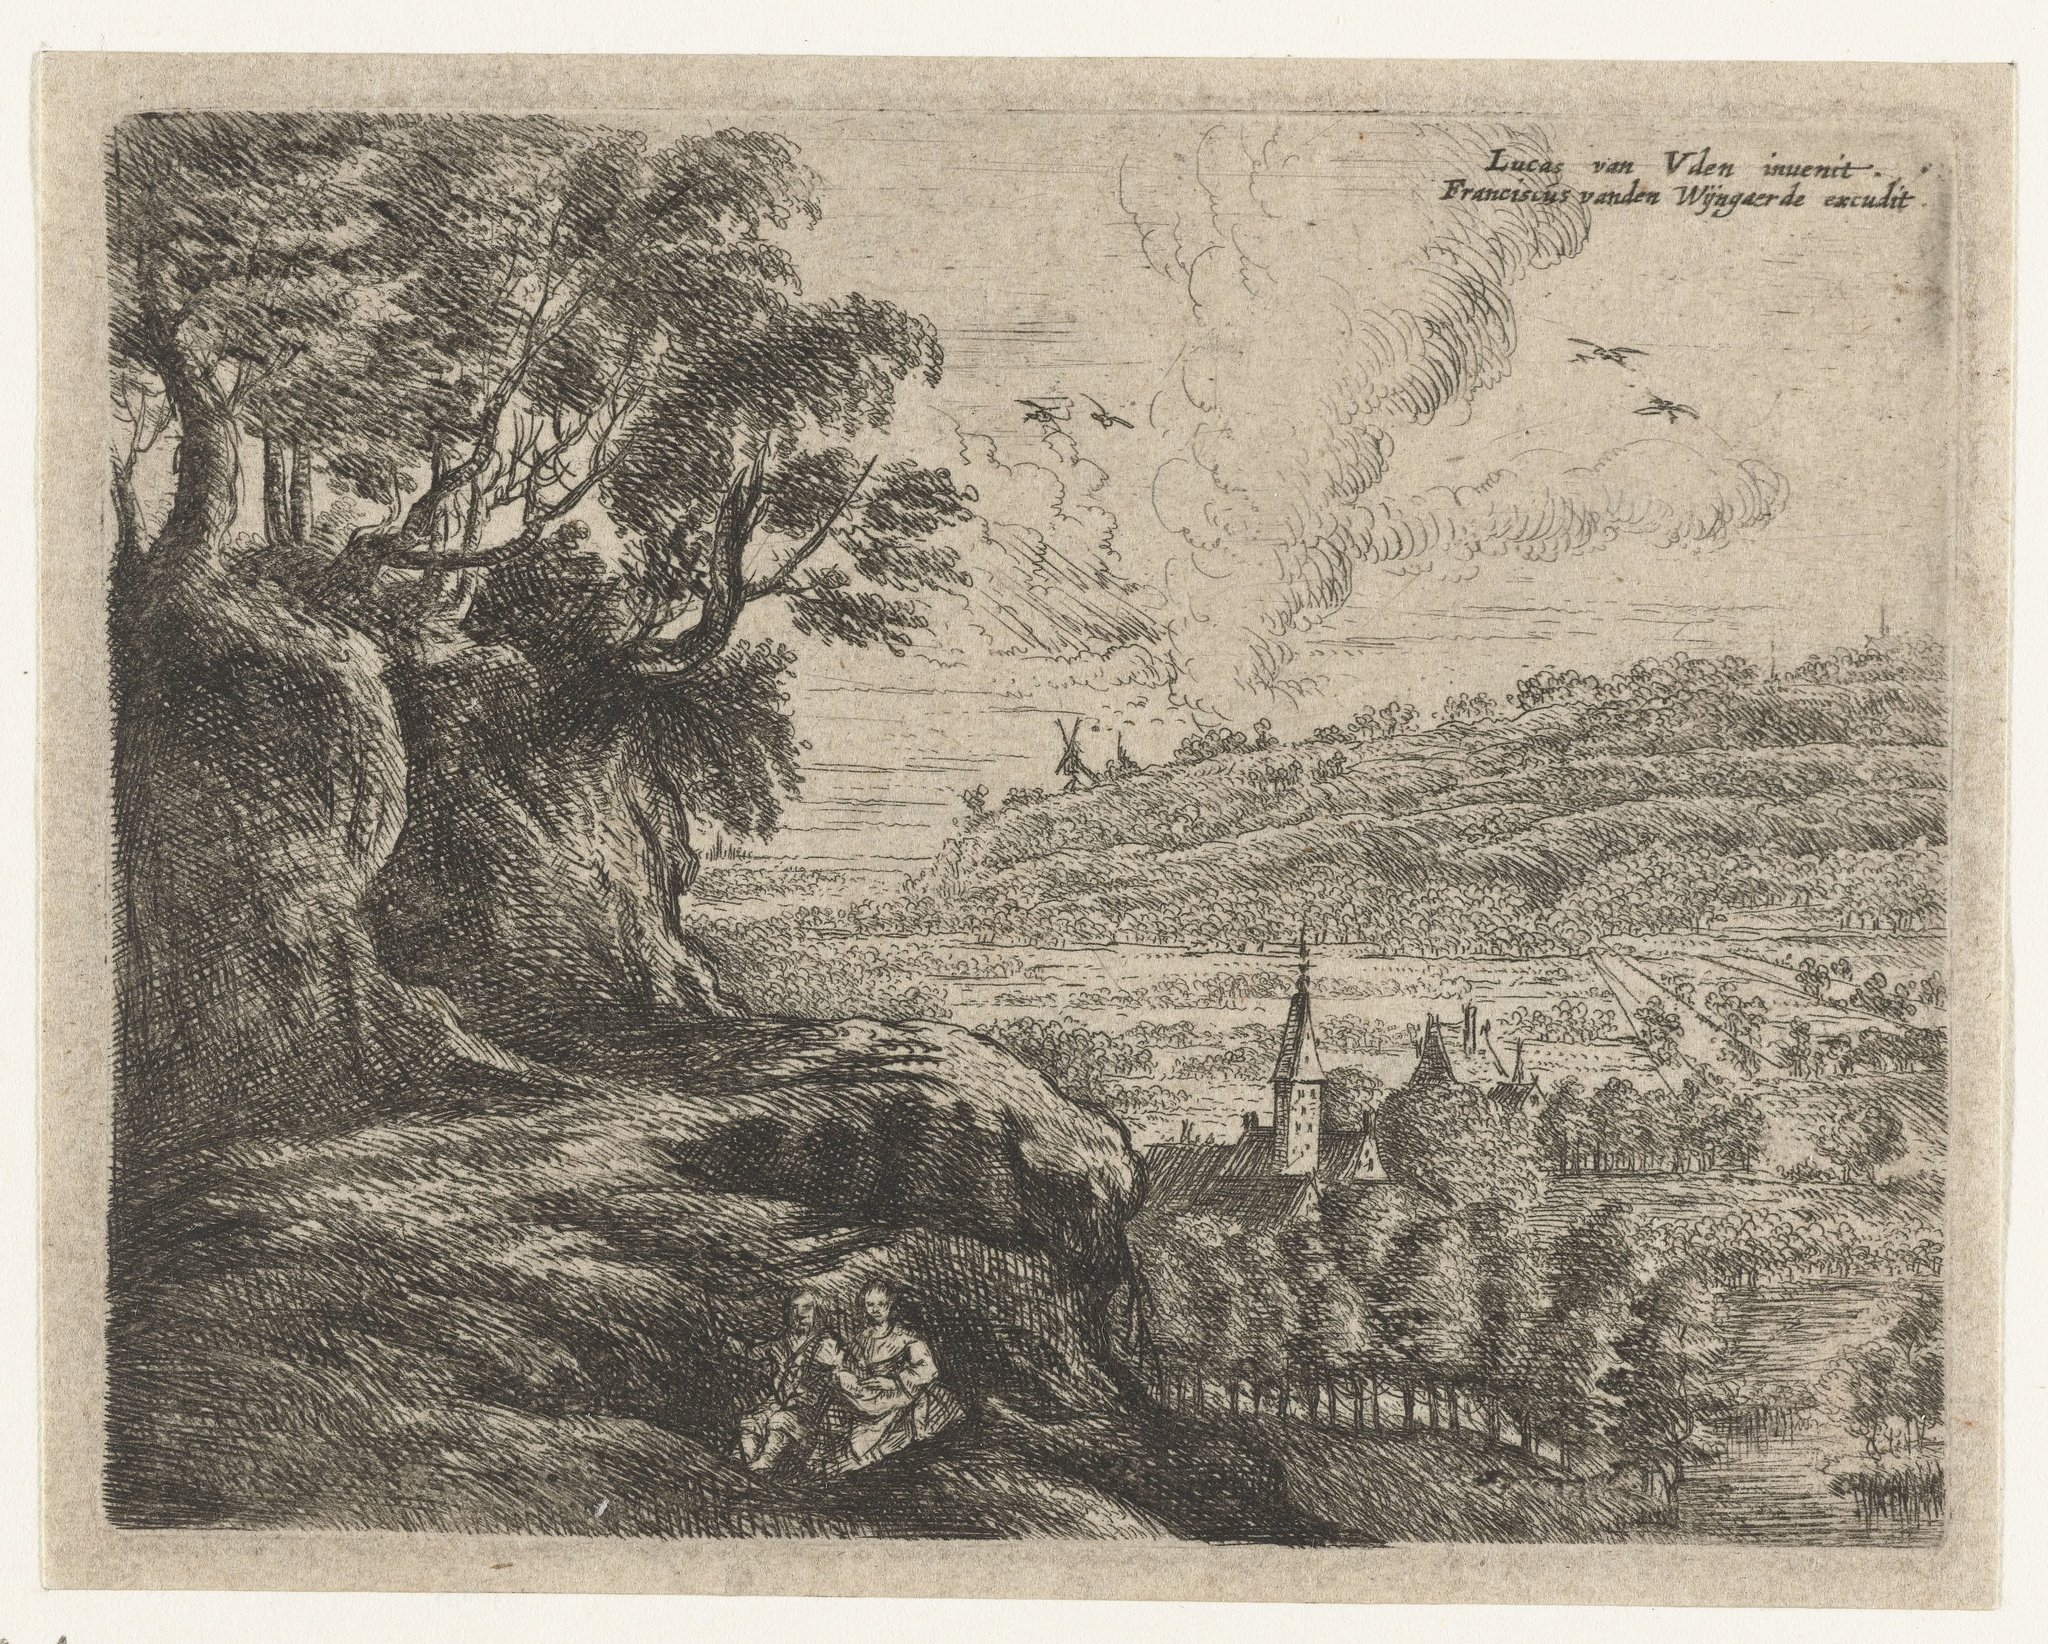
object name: print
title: Acht landschappen naar Lucas van Uden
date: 1637-1679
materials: paper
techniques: etching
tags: the (nude) human figure; 'corpo humano' (ripa) (+ three persons), landscape with tower or castle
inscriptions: collector's mark: Lugt 2228, inscription: ‘Das liebespaar am berghang vor der numer Welten sehr schöner erste abdruck’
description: Eerste uit een serie van acht. Heuvelig landschap met op de voorgrond een man en vrouw met kind.